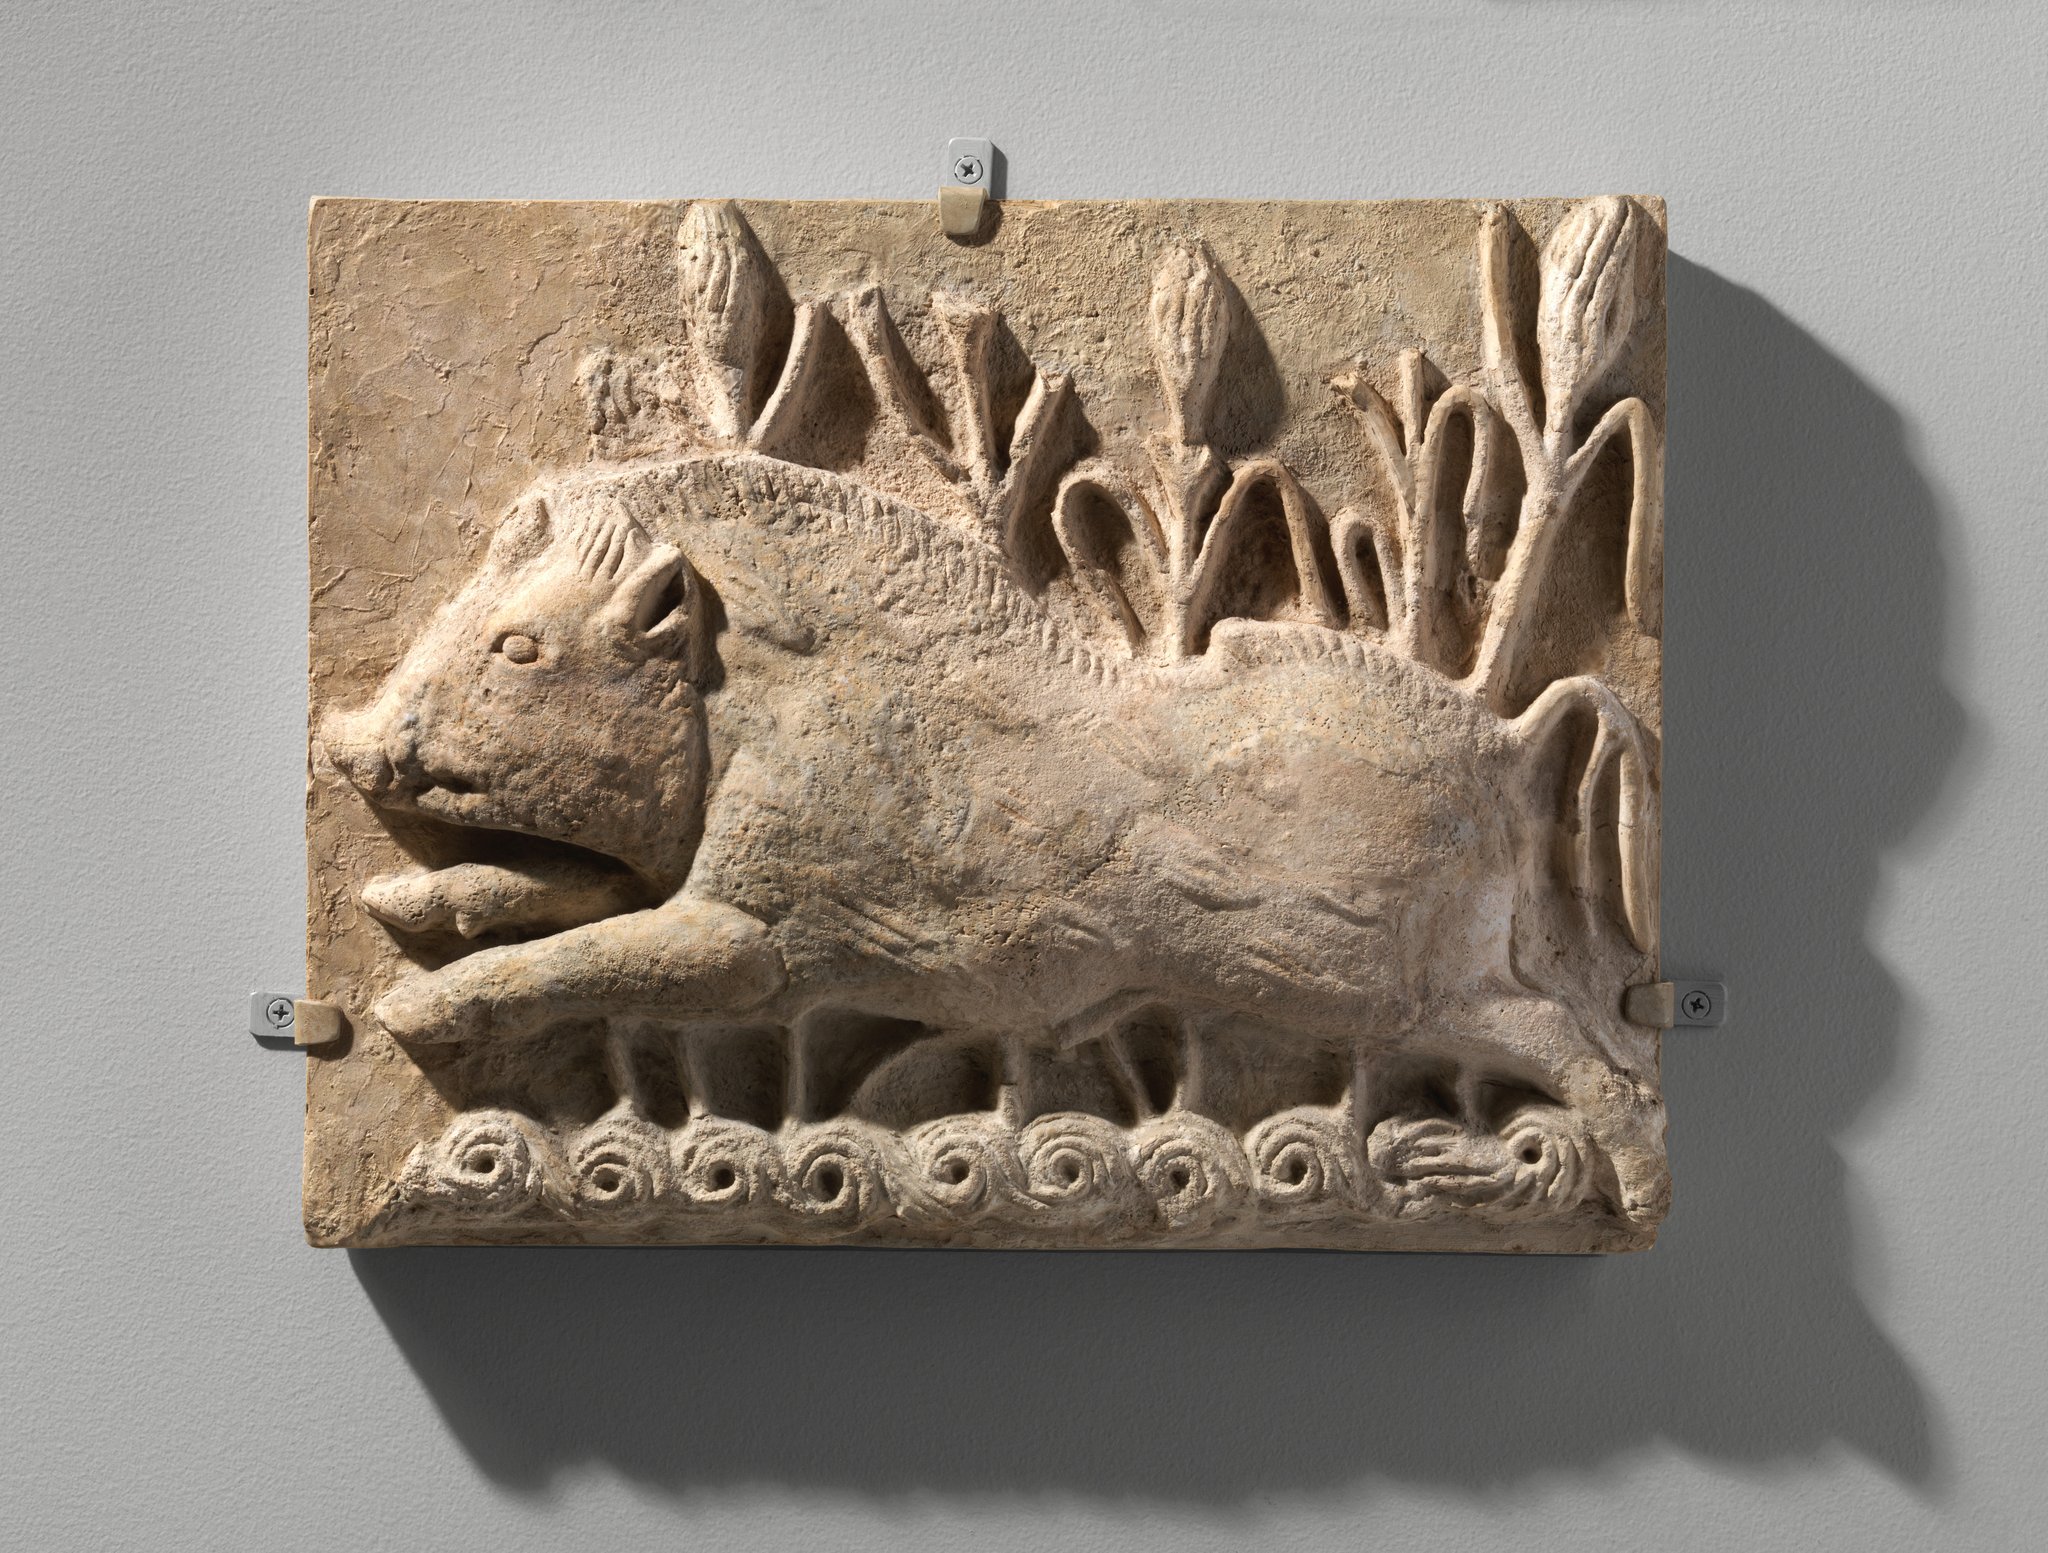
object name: relief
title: Wall panel with a charging boar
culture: sasanian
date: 501-600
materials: plaster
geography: mesopotamia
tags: boars